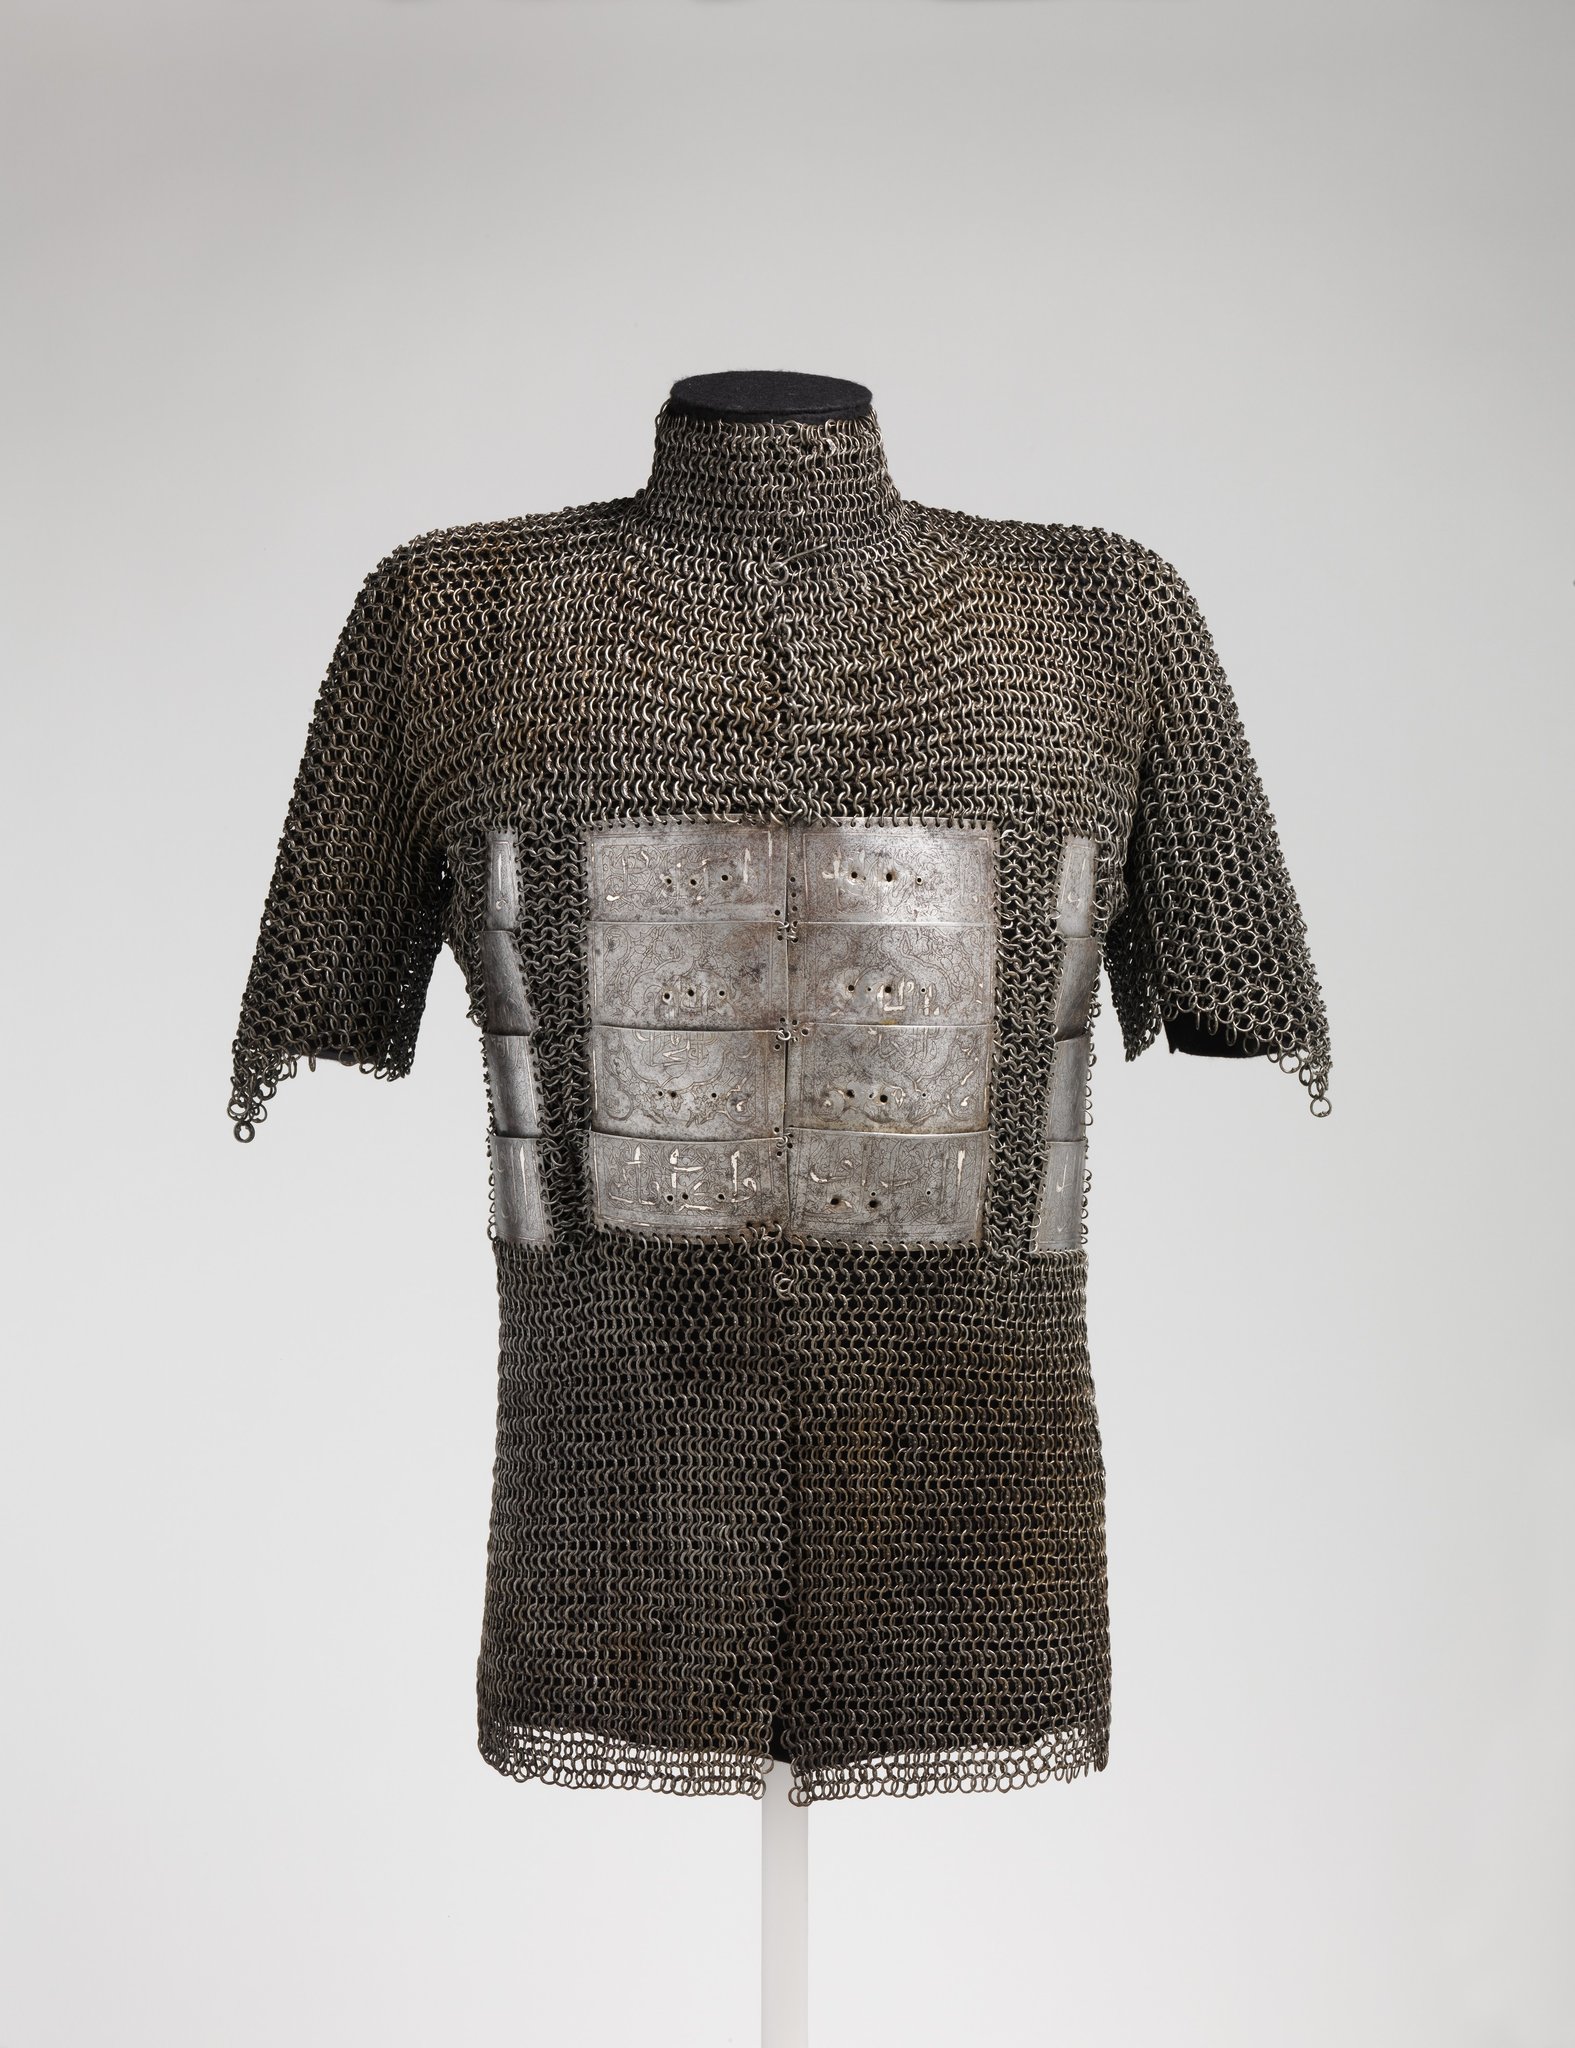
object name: shirt of mail and plate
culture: turkish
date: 1467-1600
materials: iron, silver, steel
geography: turkey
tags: arabic